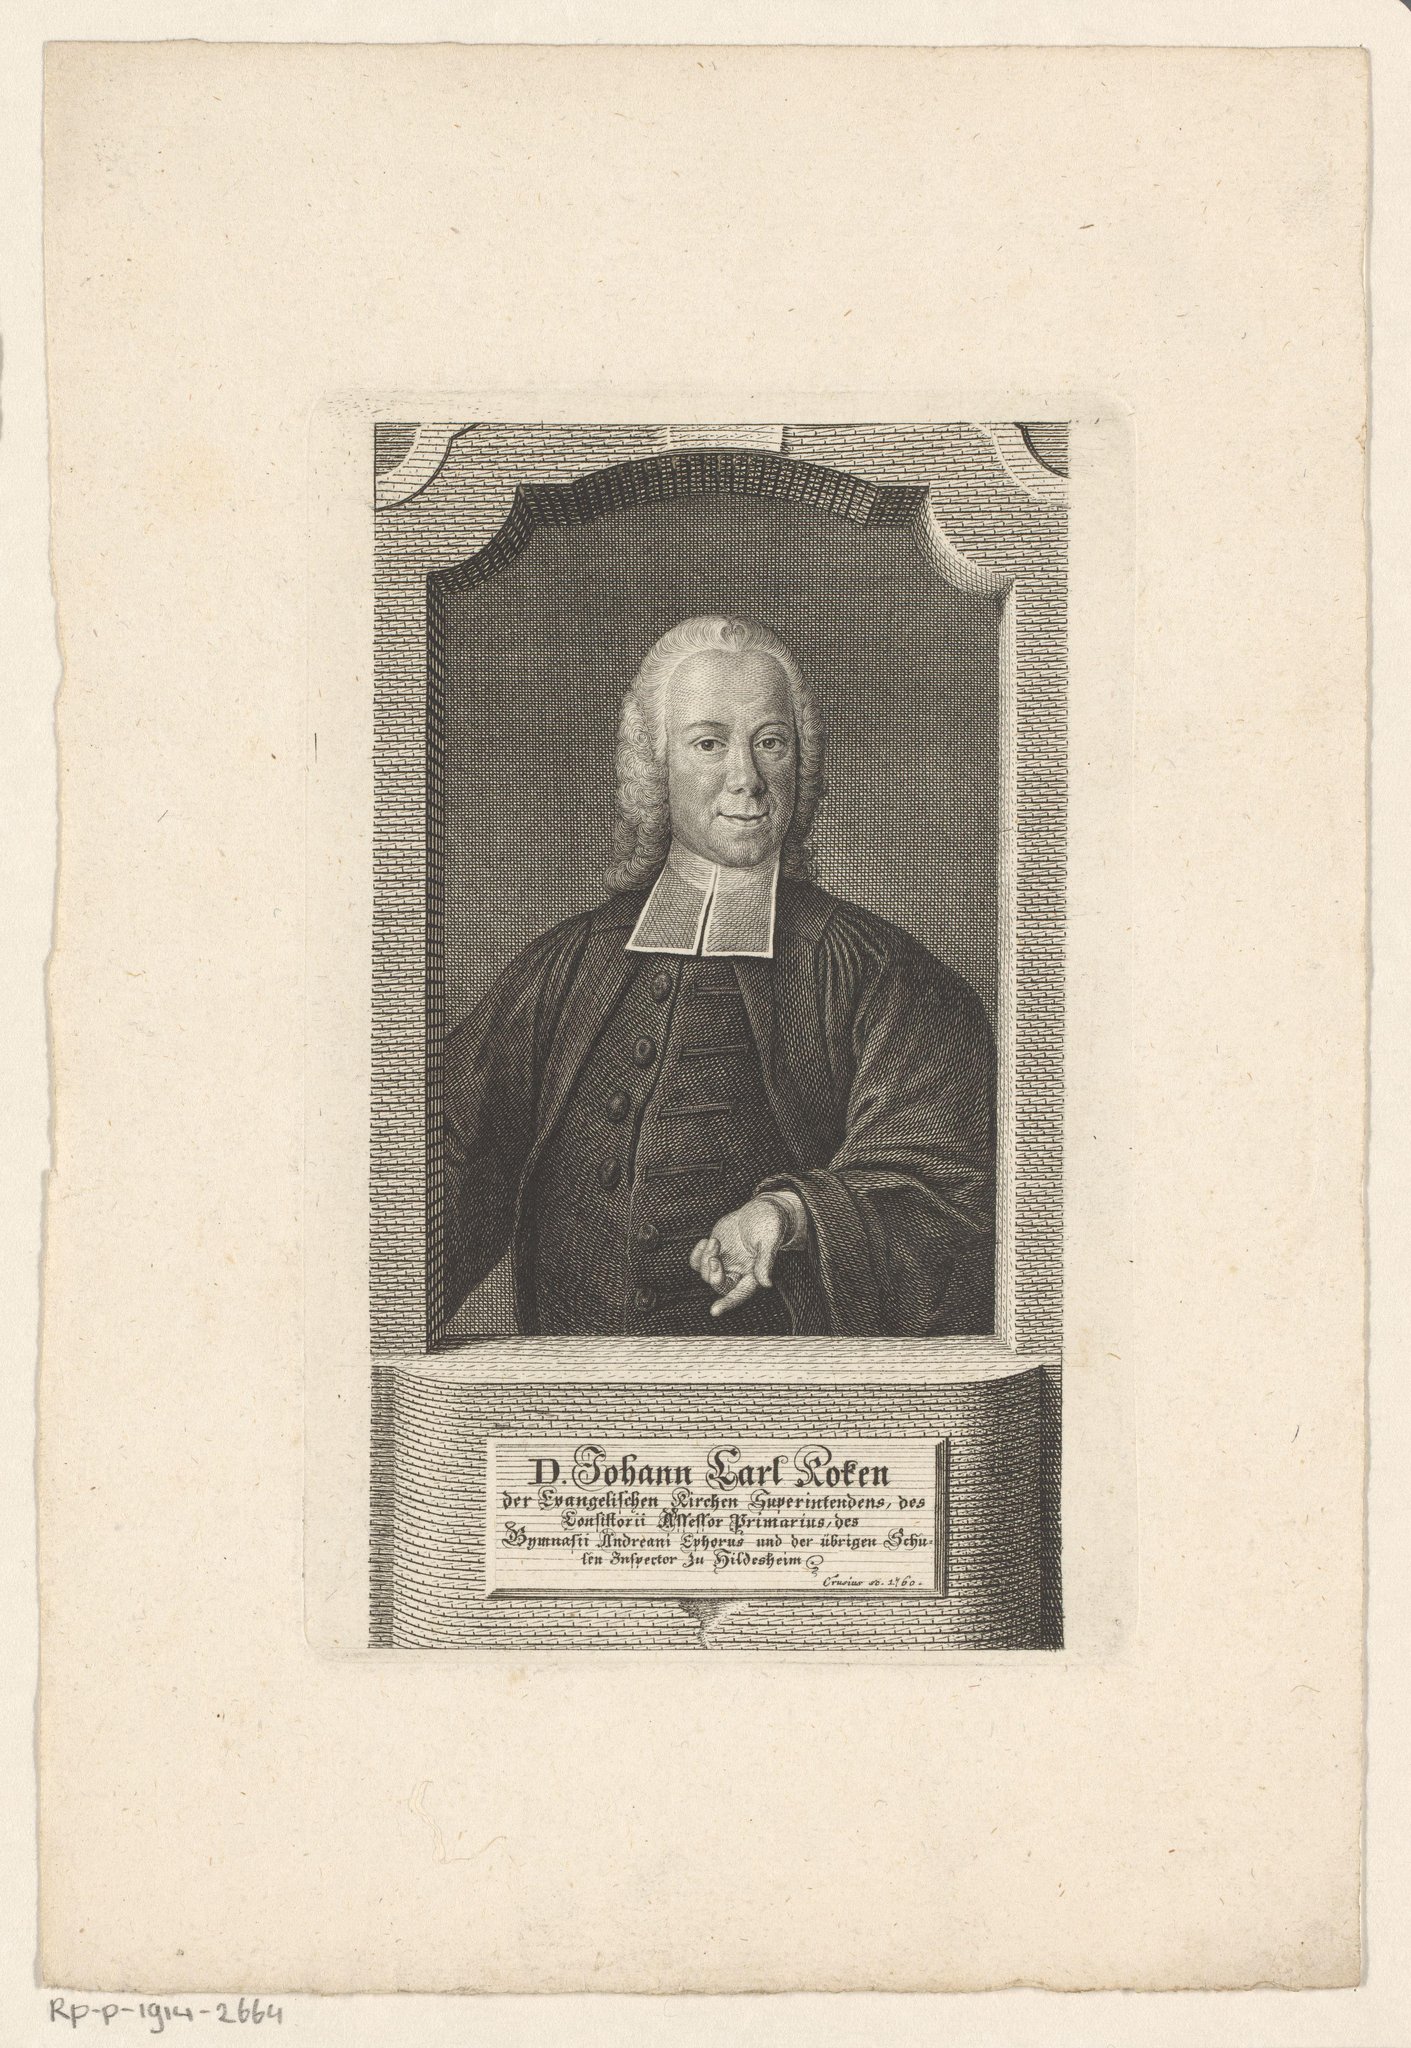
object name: print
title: D. Johann Carl Koken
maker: gottlieb leberecht crusius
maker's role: print maker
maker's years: 1730-1804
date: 1760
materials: paper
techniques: engraving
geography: leipzig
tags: historical persons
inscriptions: collector's mark: Lugt 2228